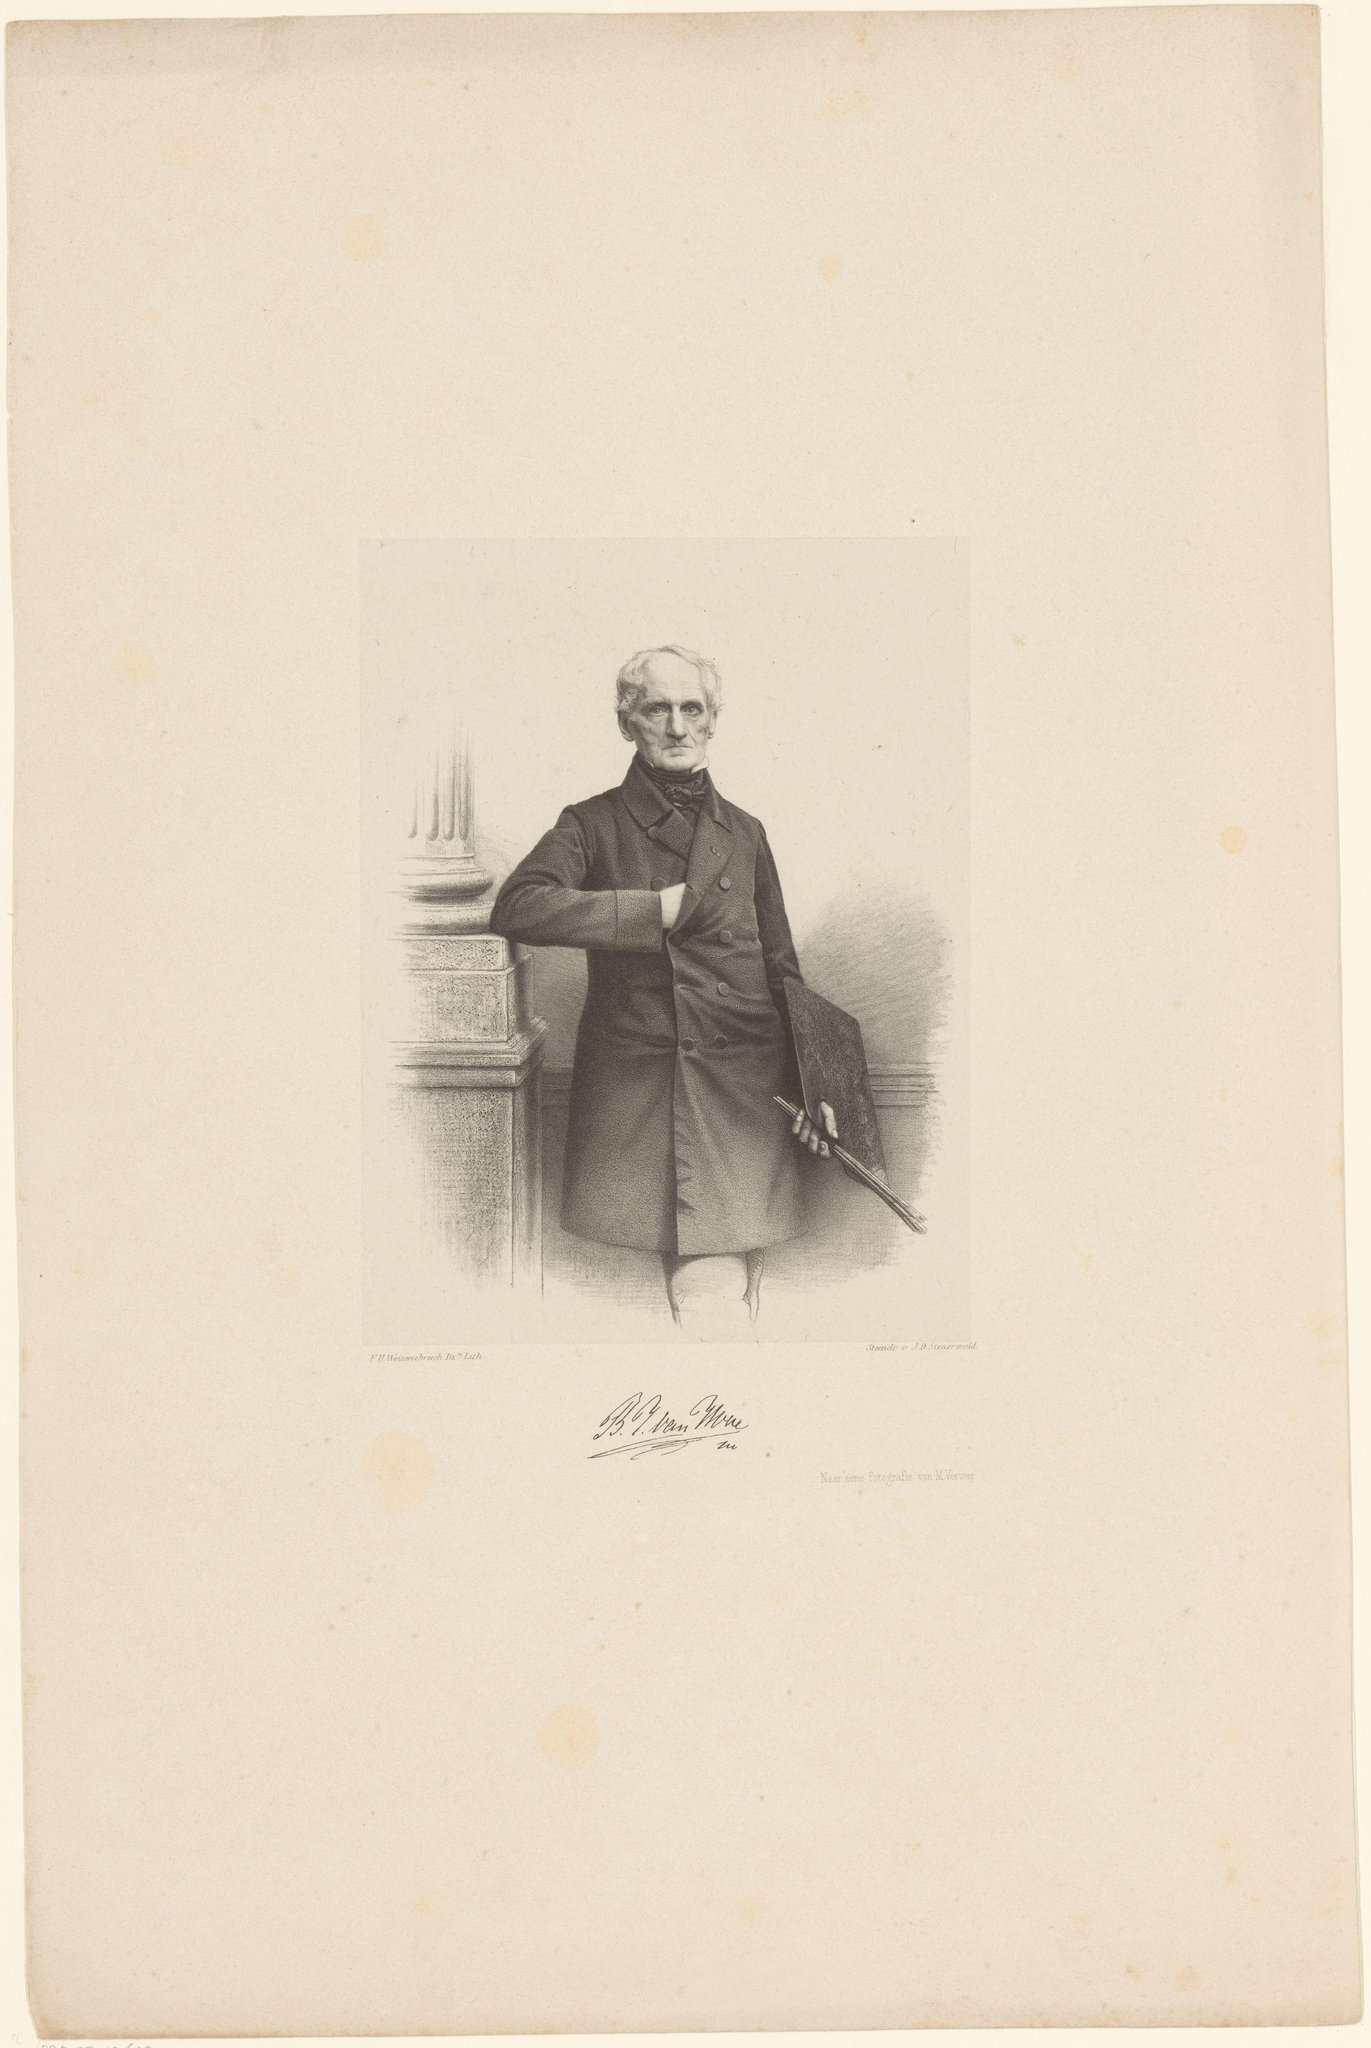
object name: print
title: Portret van Bartholomeus Johannes van Hove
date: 1861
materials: paper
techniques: lithograph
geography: the hague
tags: the hague, painter, print maker, draughtsman, bartholomeus johannes van hove, historical persons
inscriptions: collector's mark: Lugt 2228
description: Onder het portret de signatuur van de geportretteerde.